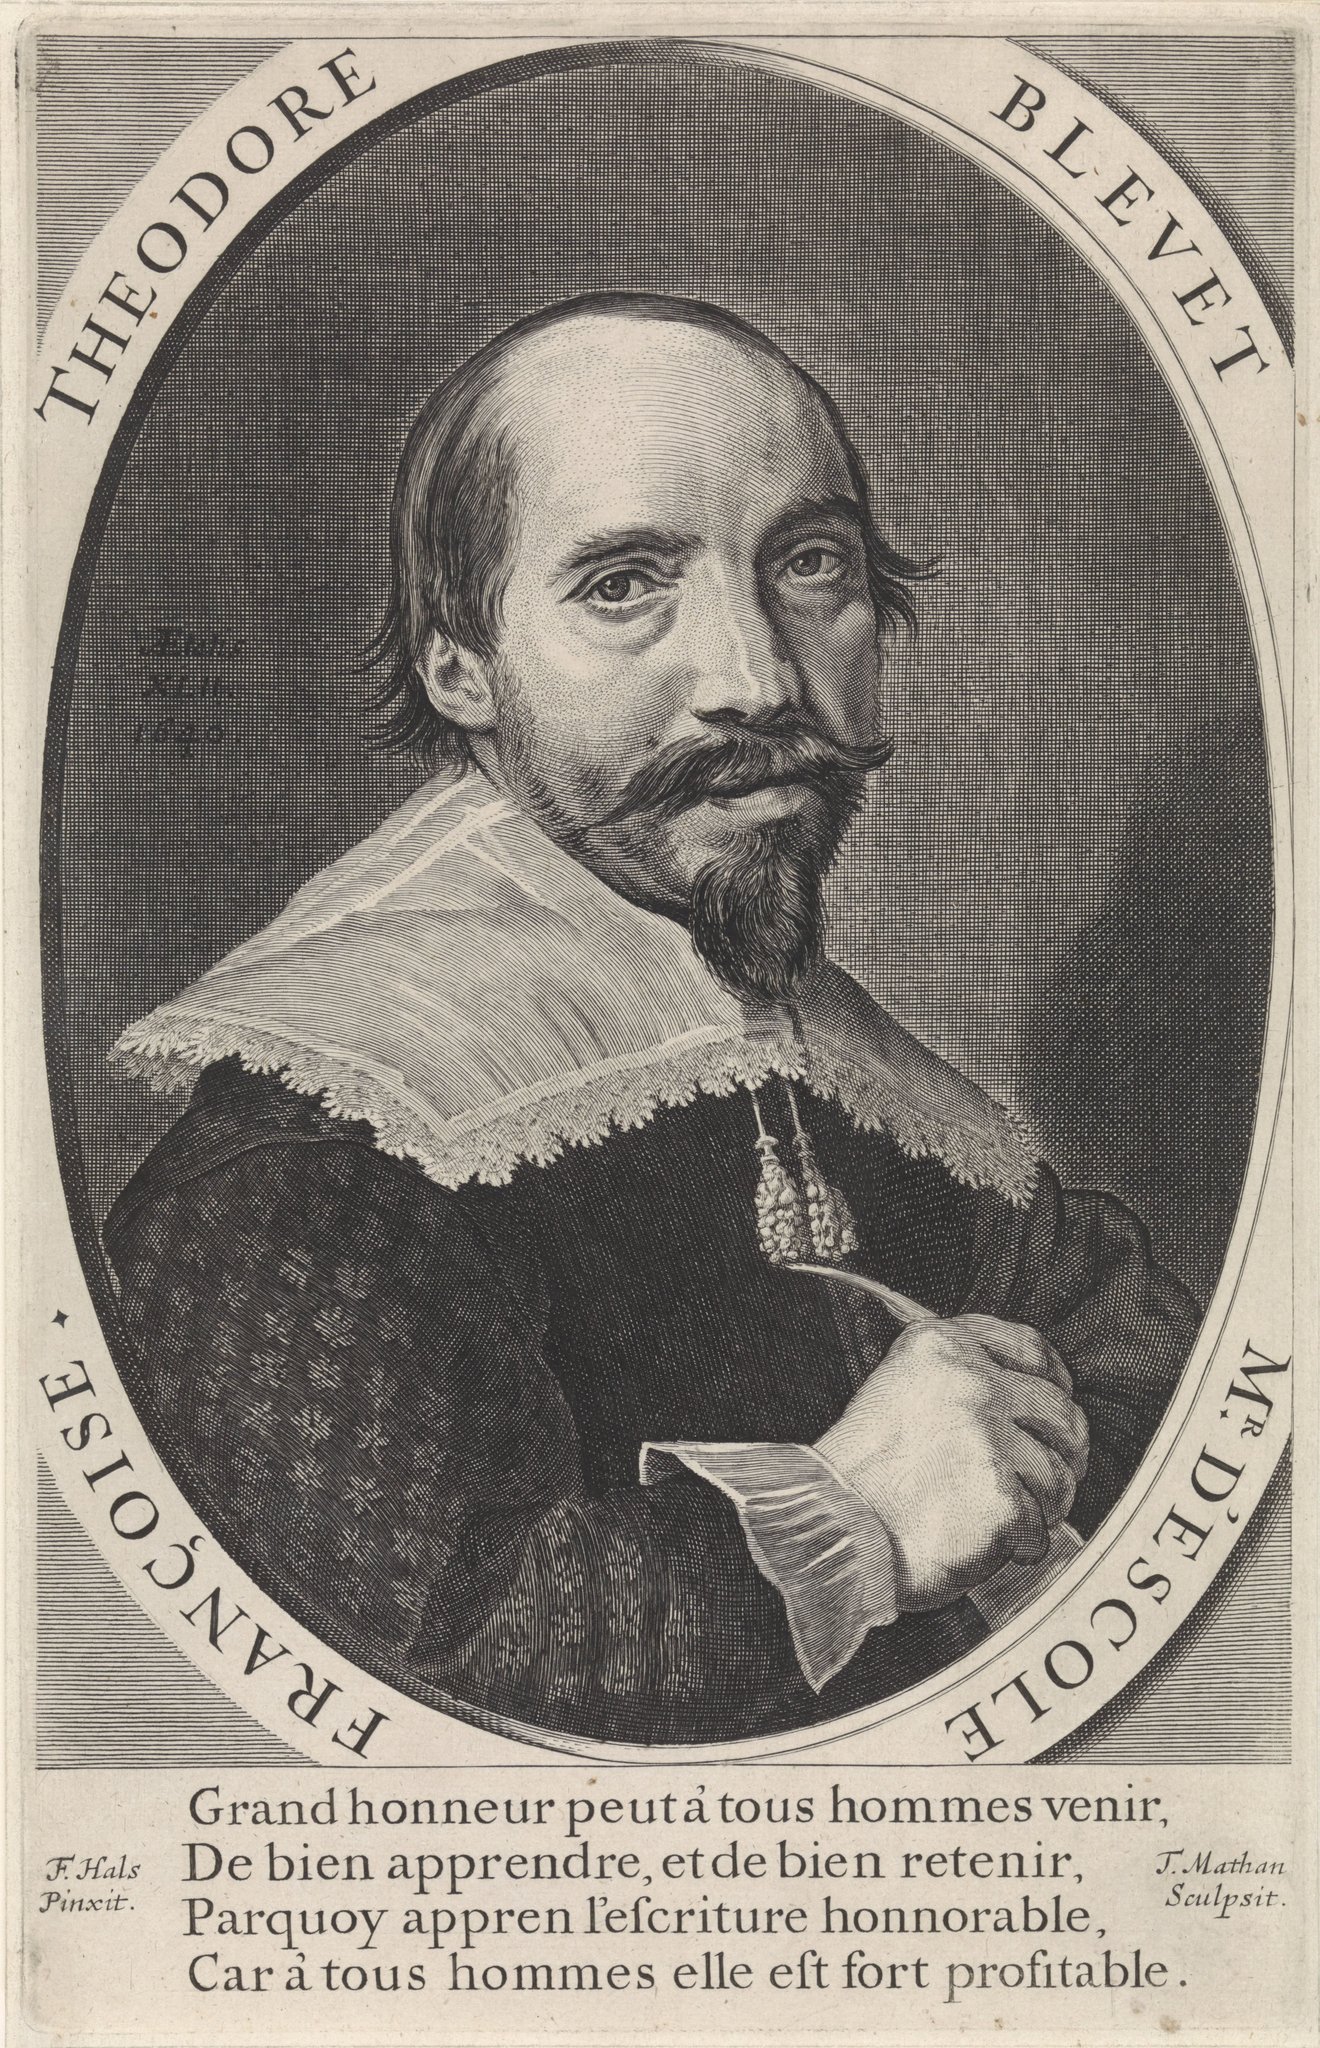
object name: print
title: Portret van Theodore Bleuet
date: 1640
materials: paper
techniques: engraving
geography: haarlem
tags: quill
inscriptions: collector's mark: Lugt 240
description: Portret van de schoolmeester en schoonschrijver Theodore Bleuet op 42-jarigeleeftijd met een schrijfveer in de hand.